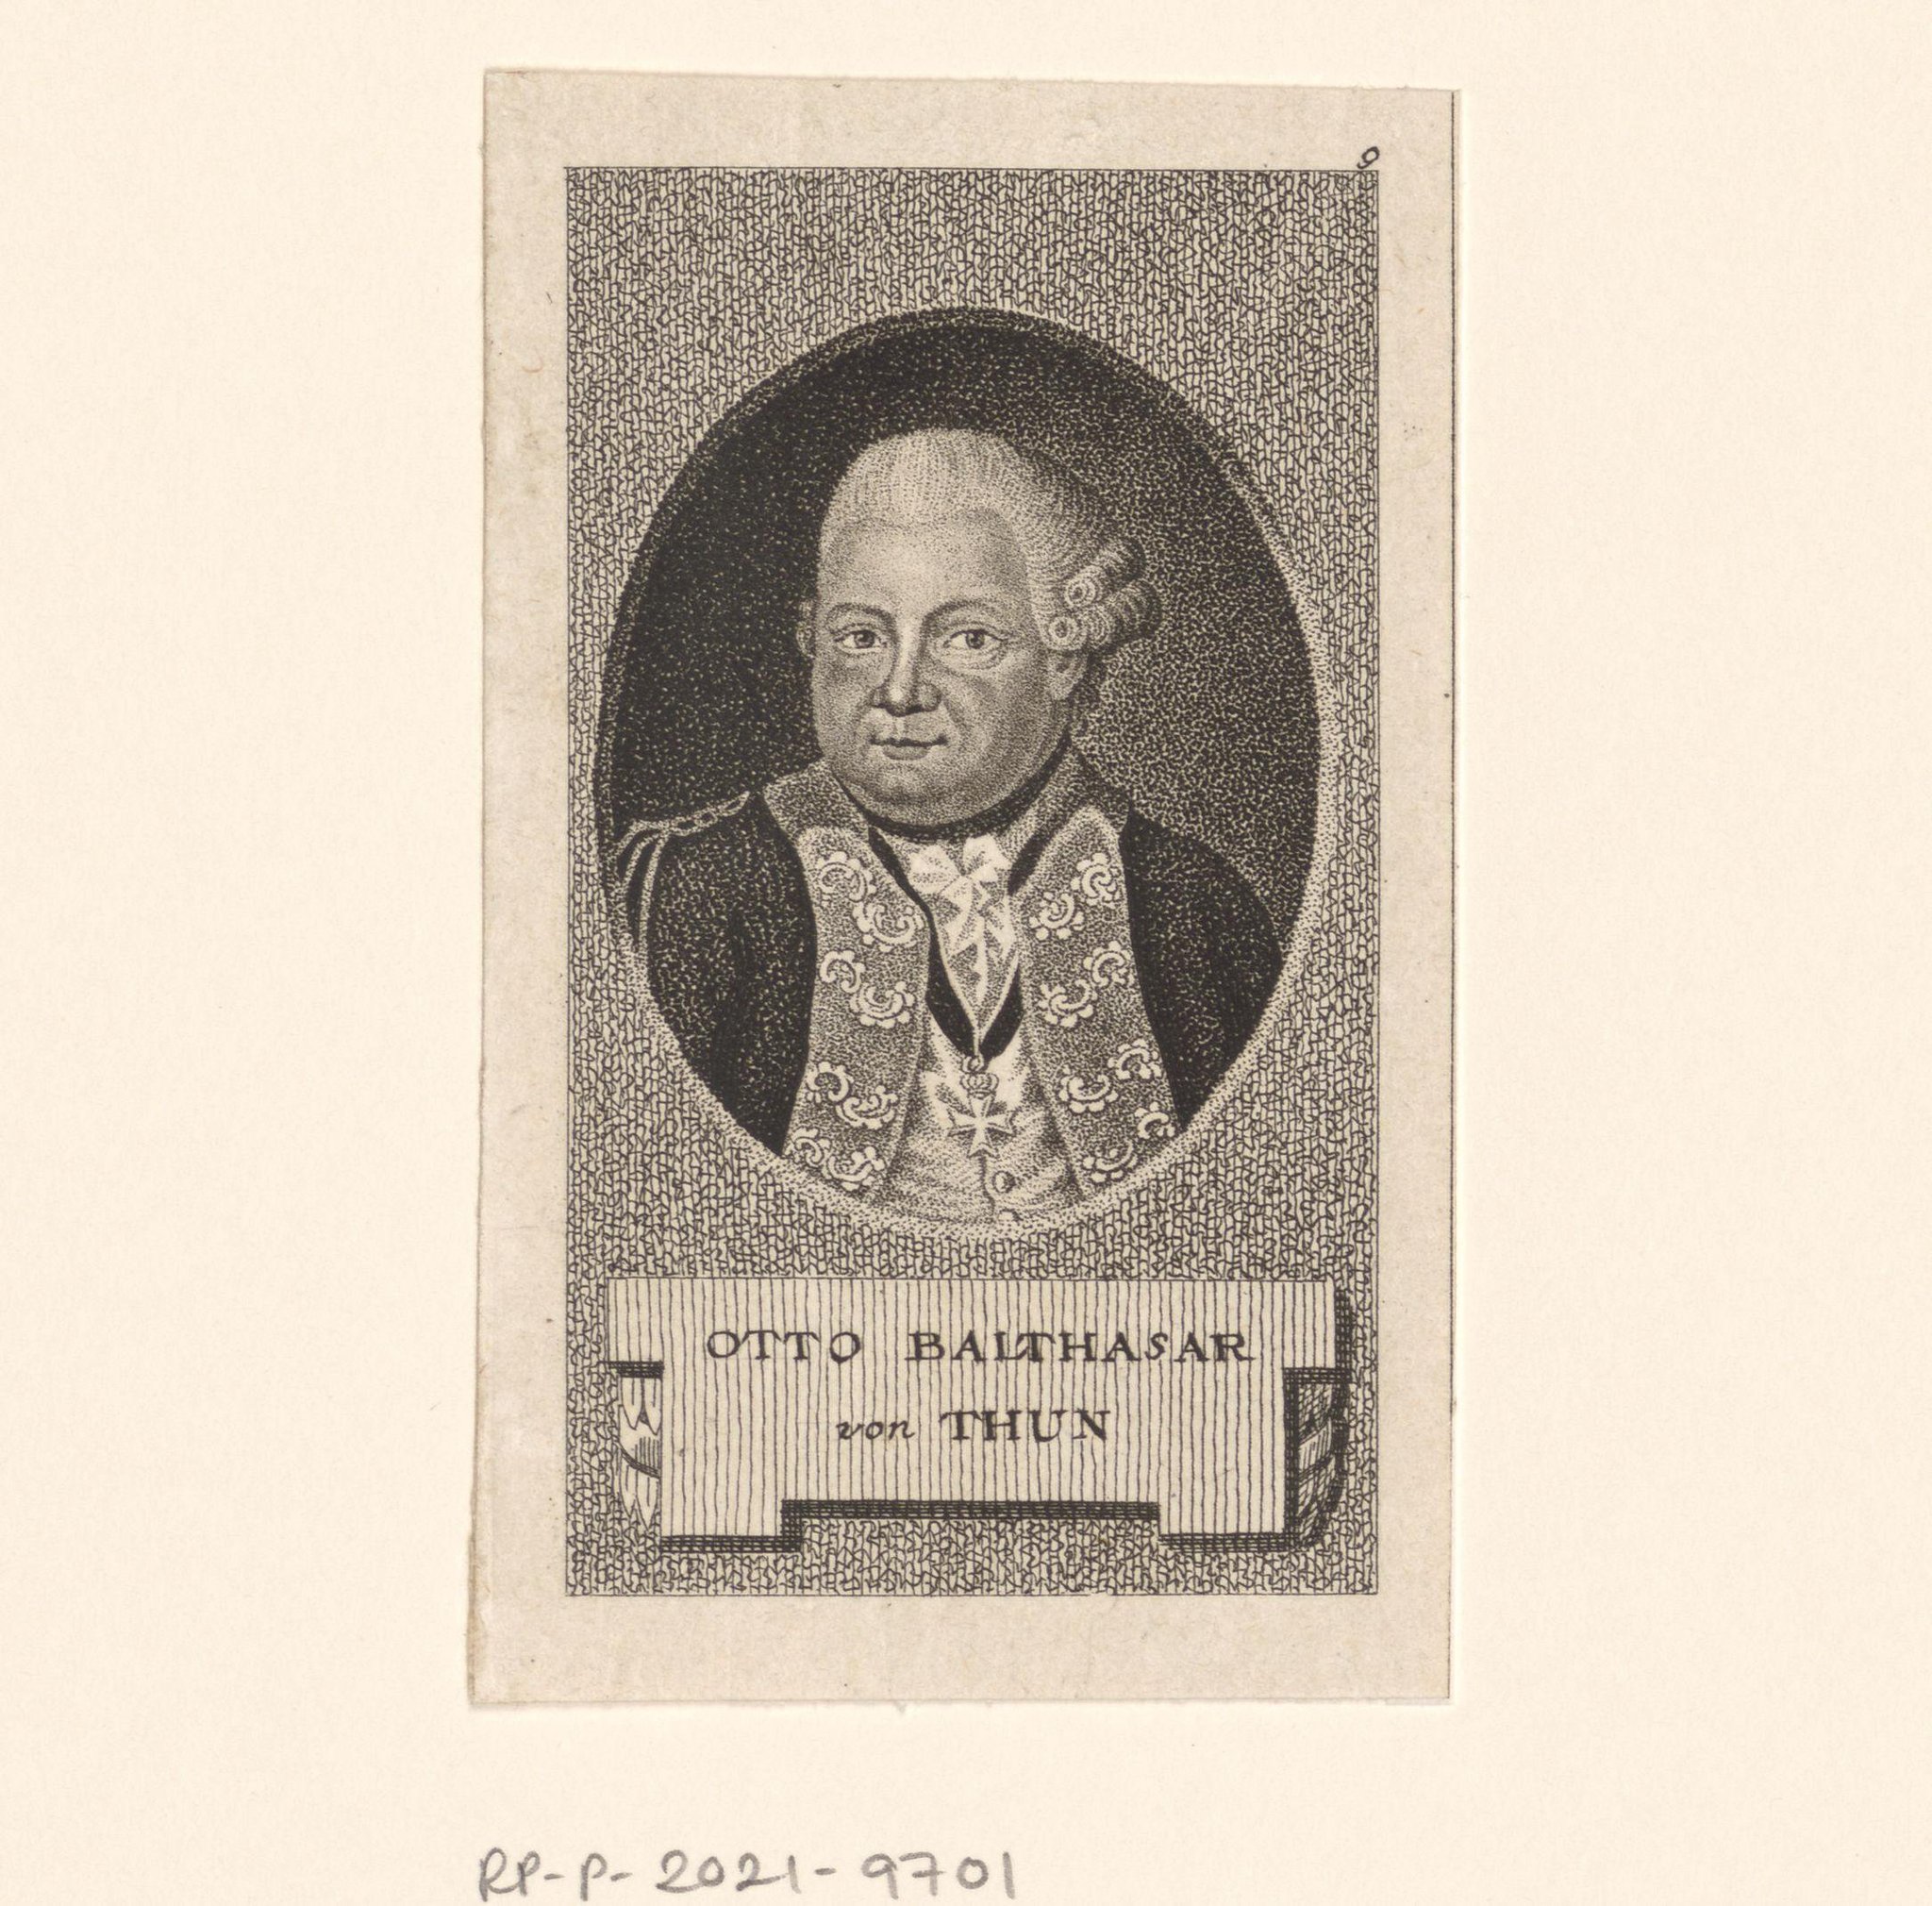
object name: print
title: Portret van Otto Balthasar von Thun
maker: Anonymous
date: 1775-1824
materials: paper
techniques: etching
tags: commander-in-chief, general, marshal, historical persons